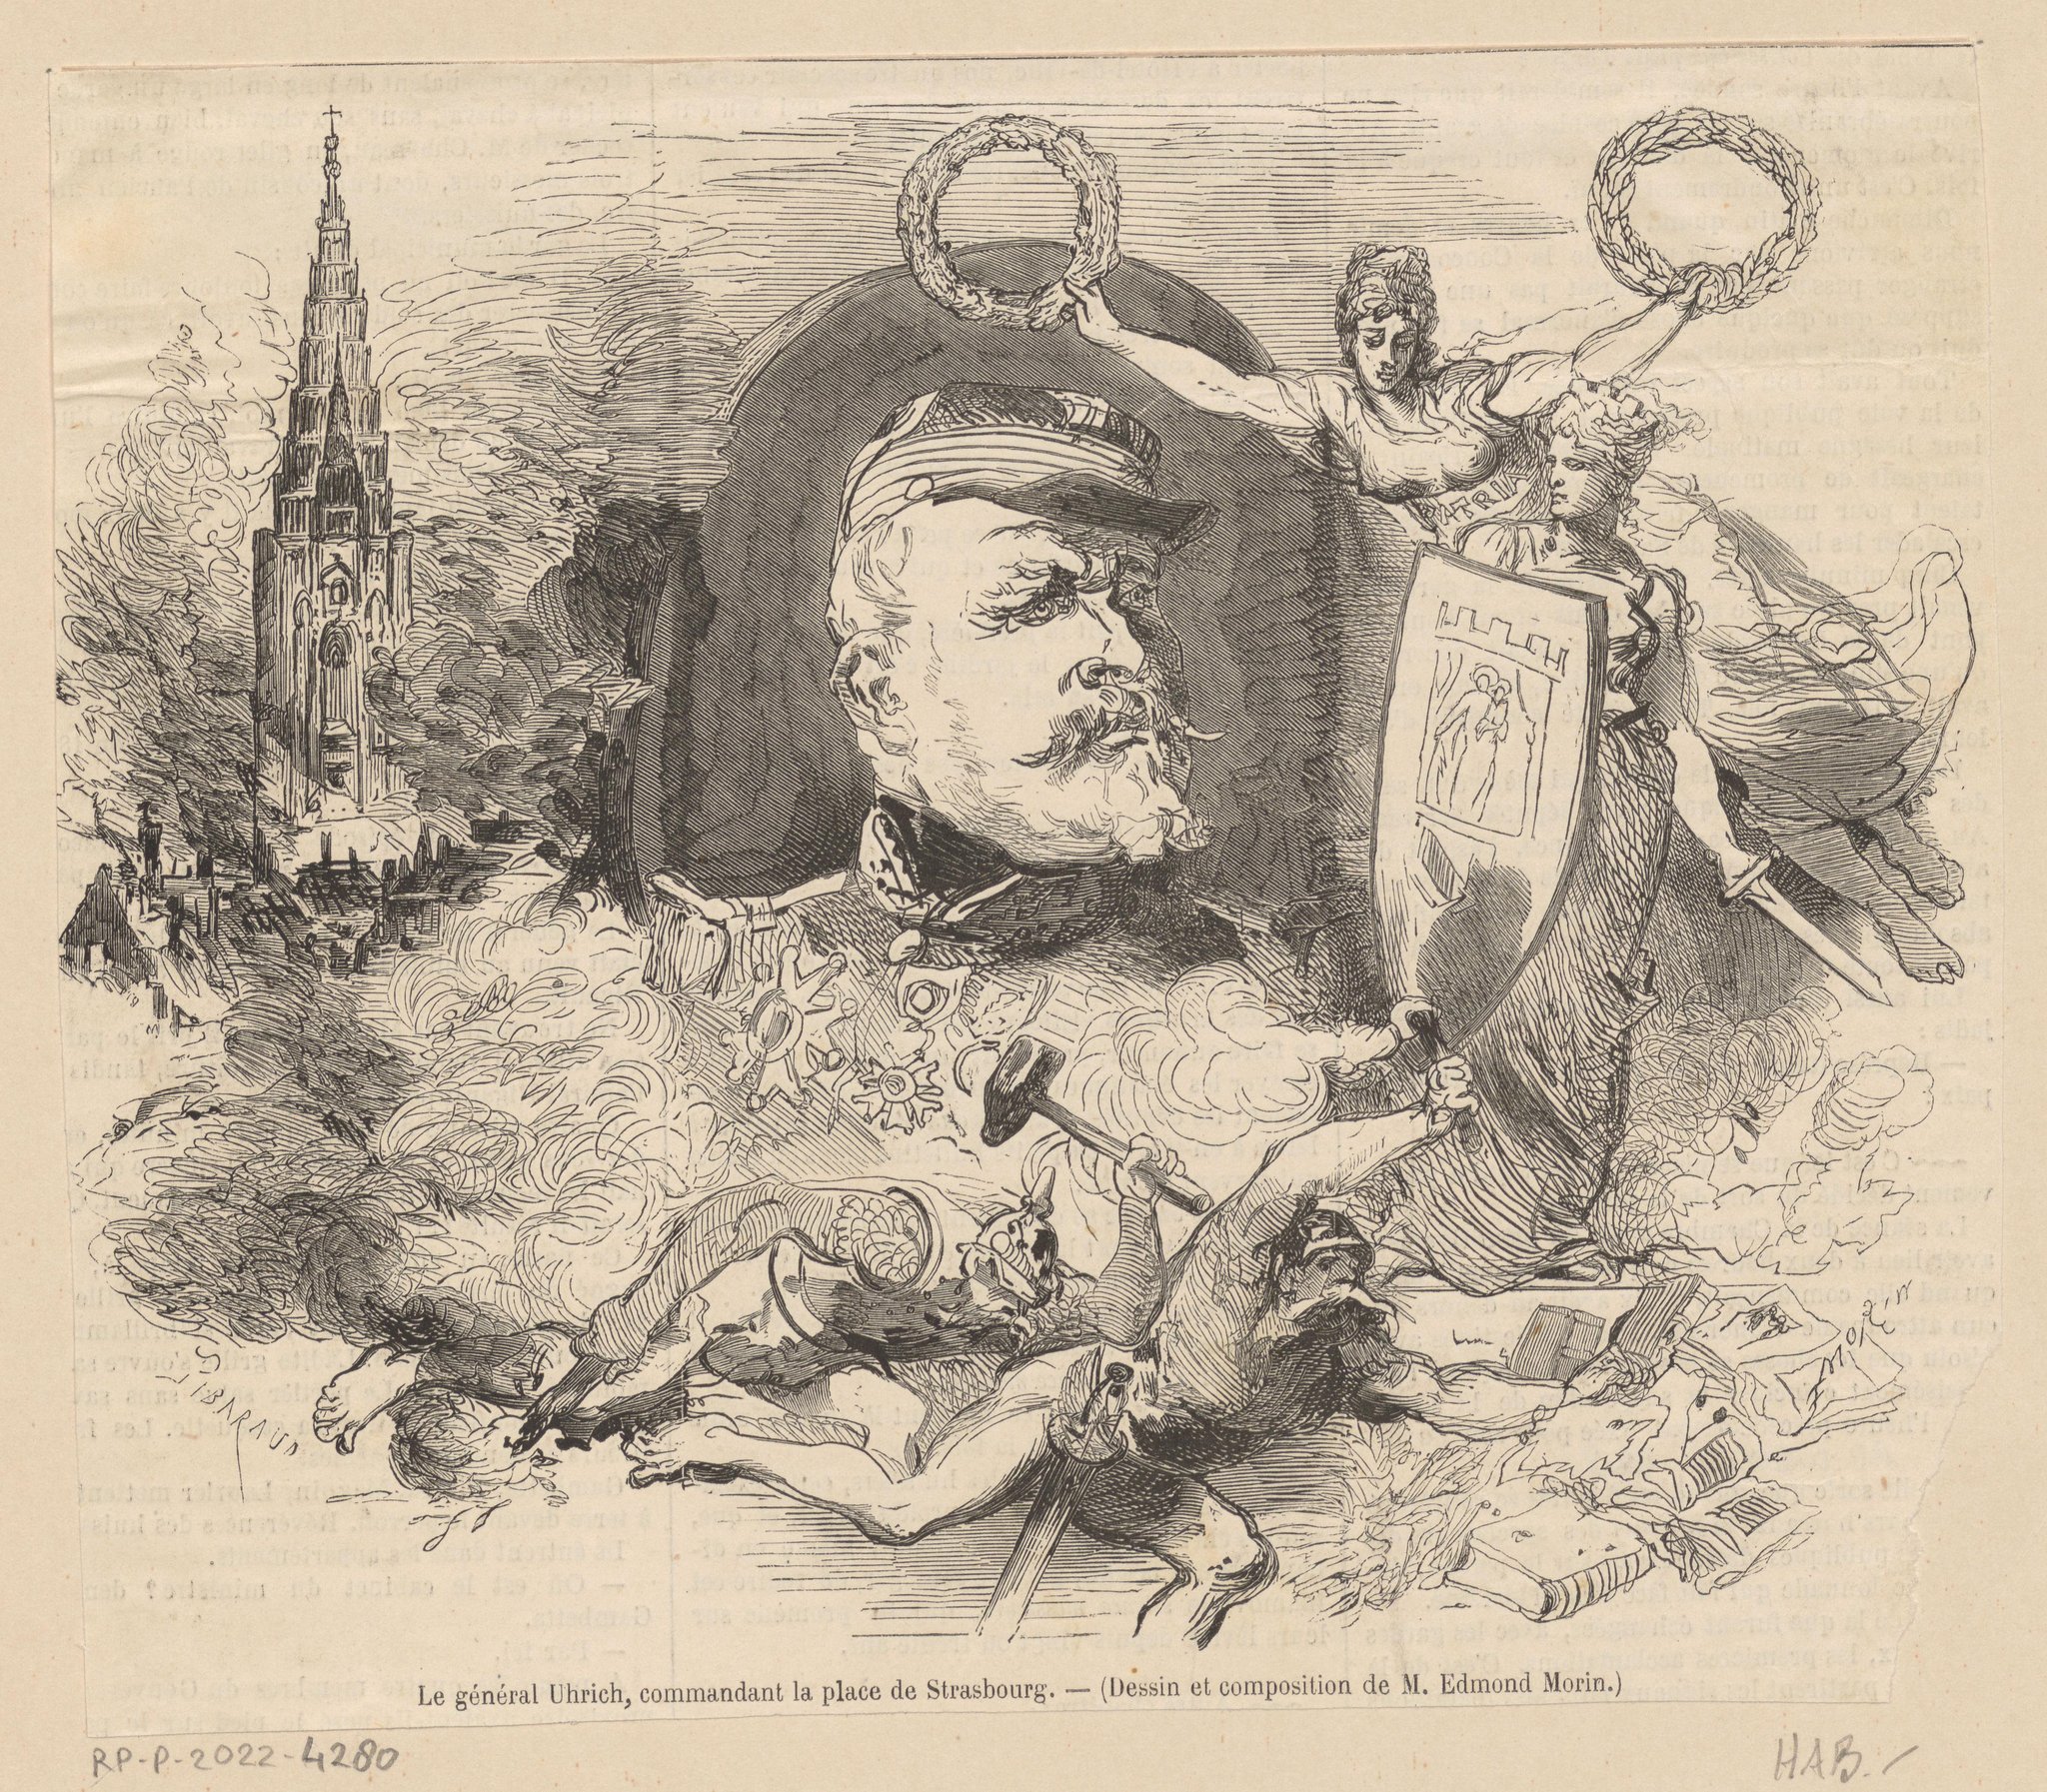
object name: print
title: Portret van Jean-Jacques Uhrich met een allegorische voorstelling op het beleg van Straatsburg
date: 1870-1882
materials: paper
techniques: letterpress printing, engraving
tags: torch, garland, wreath, commander-in-chief, general, marshal, historical persons, hacking and thrusting weapons: sword, tools, aids, implements ~ crafts and industries: hammer, medals and other marks of military honour, armorial bearing, heraldry, parts of church exterior and annexes: tower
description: Prent uit een onbekende publicatie, mogelijk Le Monde Illustré.